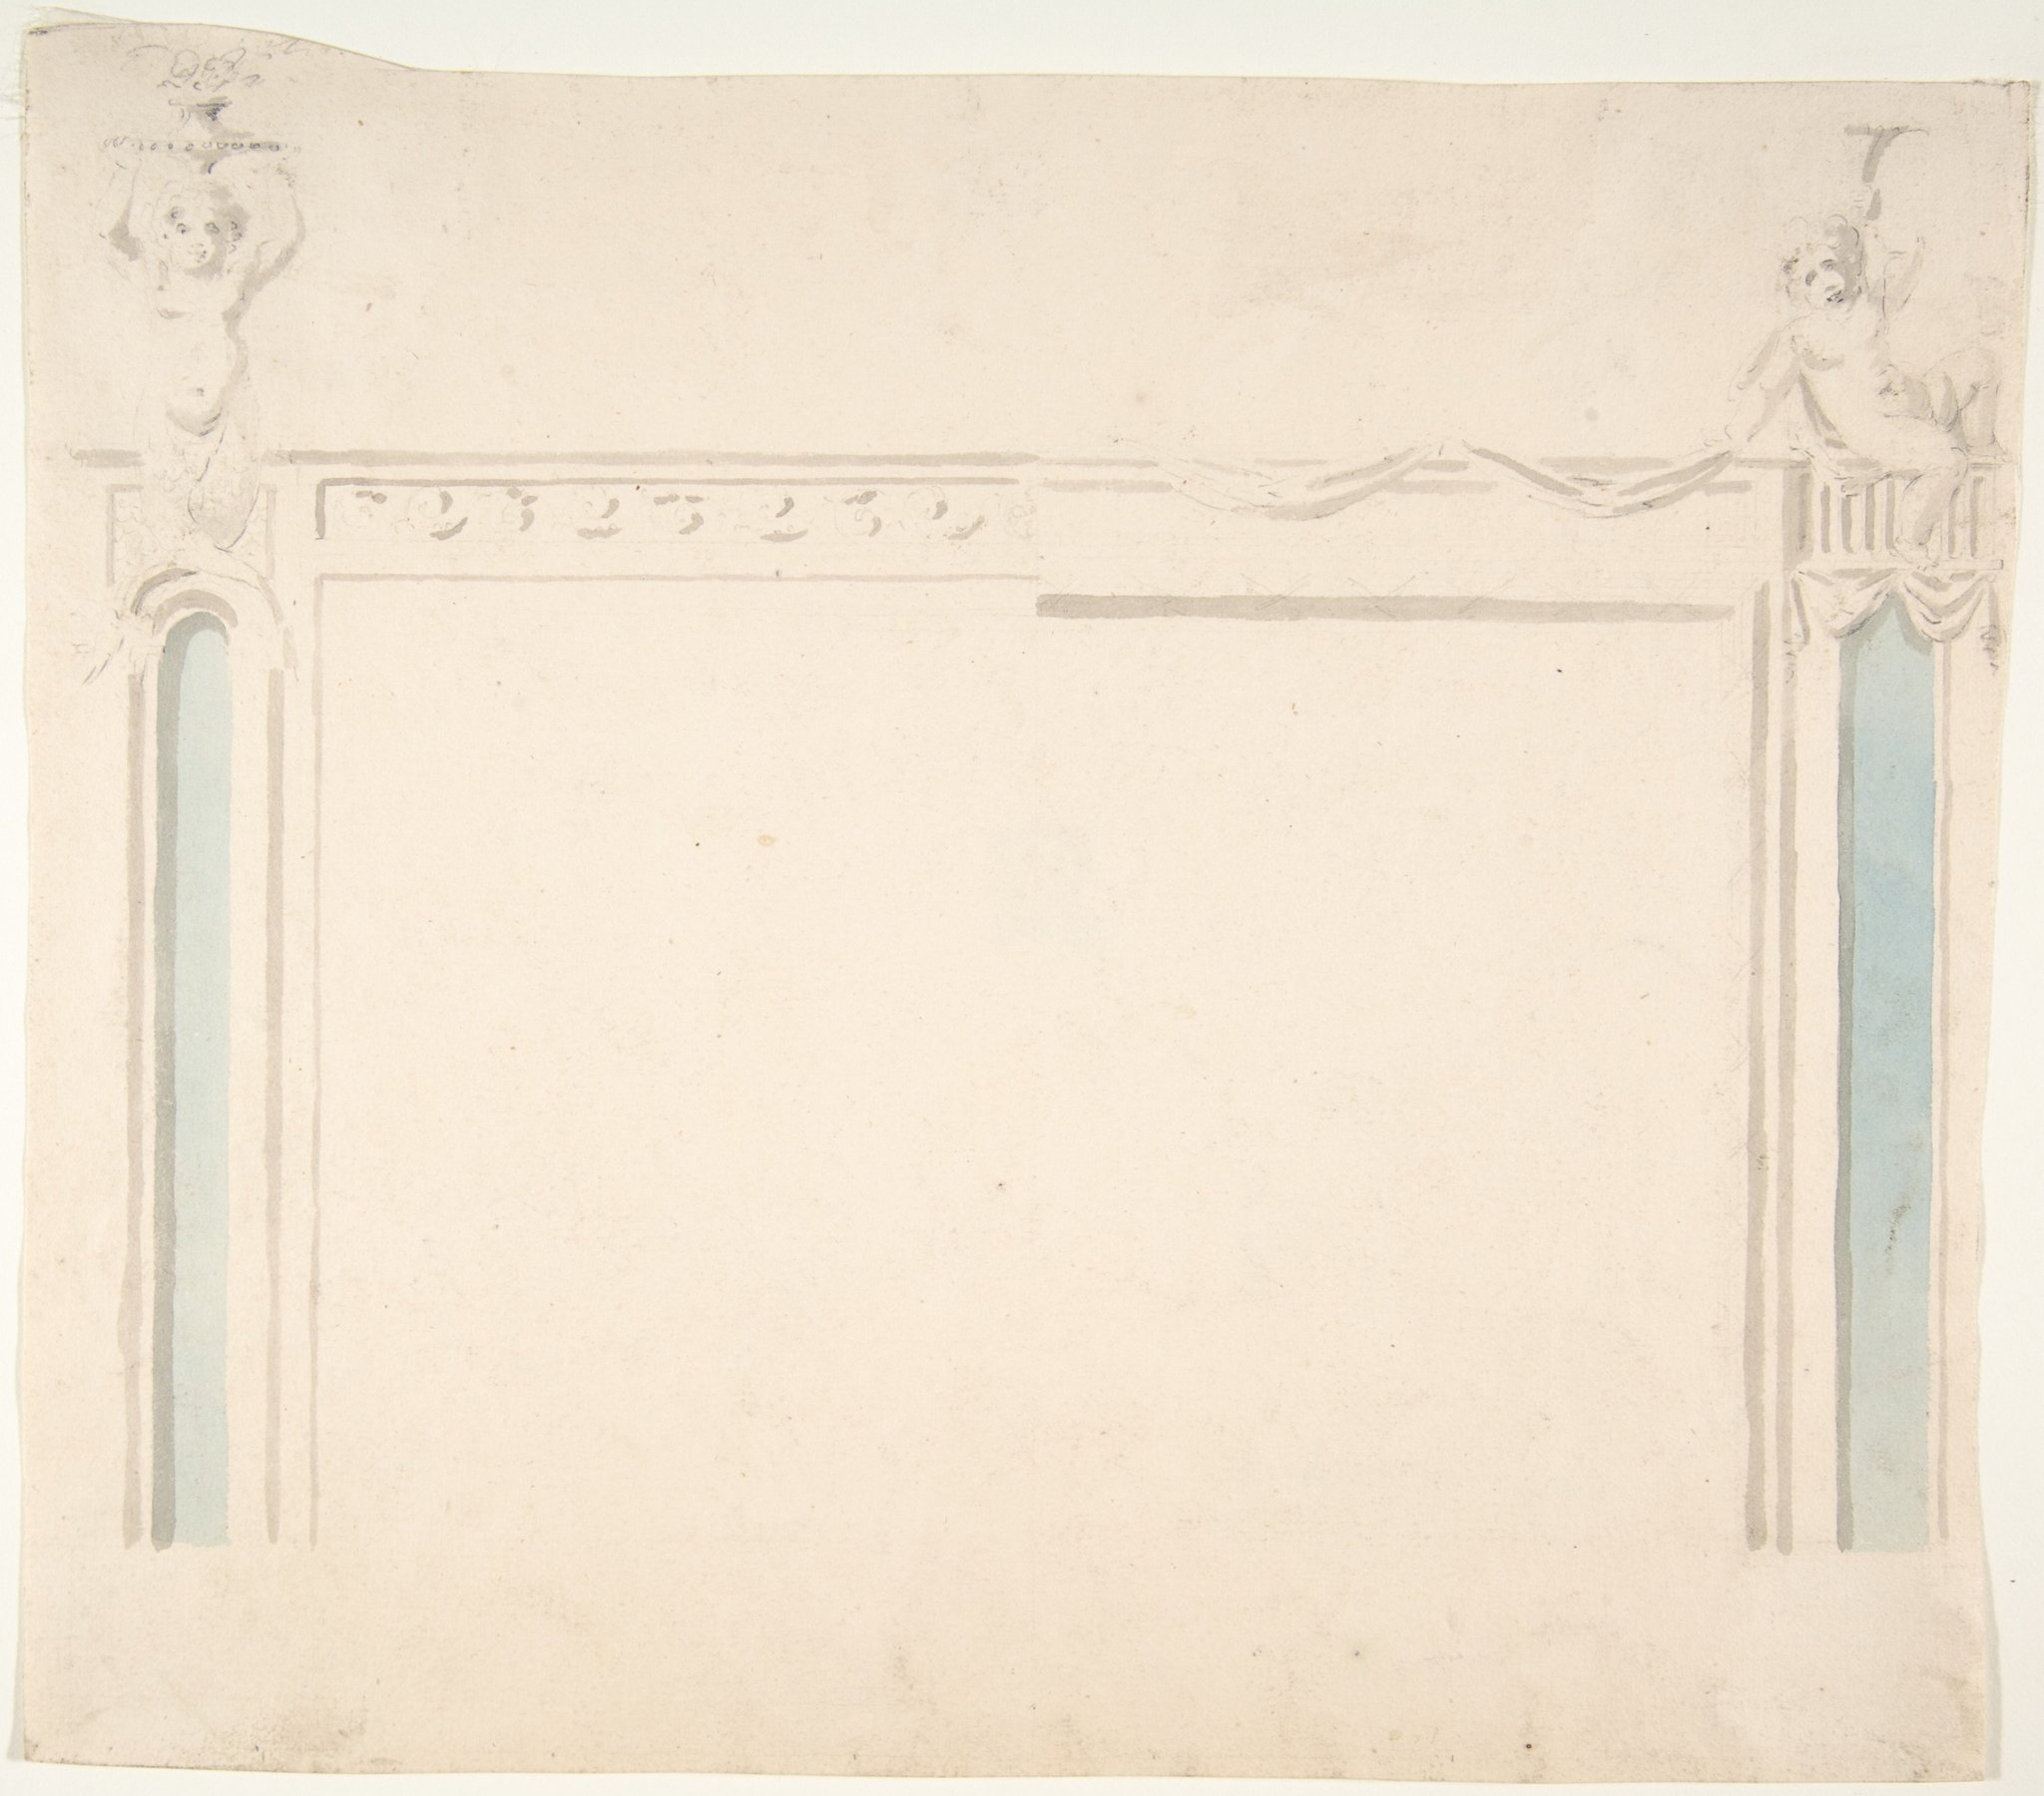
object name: drawing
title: Design for a Chimney Piece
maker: anonymous, british, 18th century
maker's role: artist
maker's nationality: british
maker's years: 1700-1800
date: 1767-1800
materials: graphite, watercolor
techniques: brush, wash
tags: fireplaces